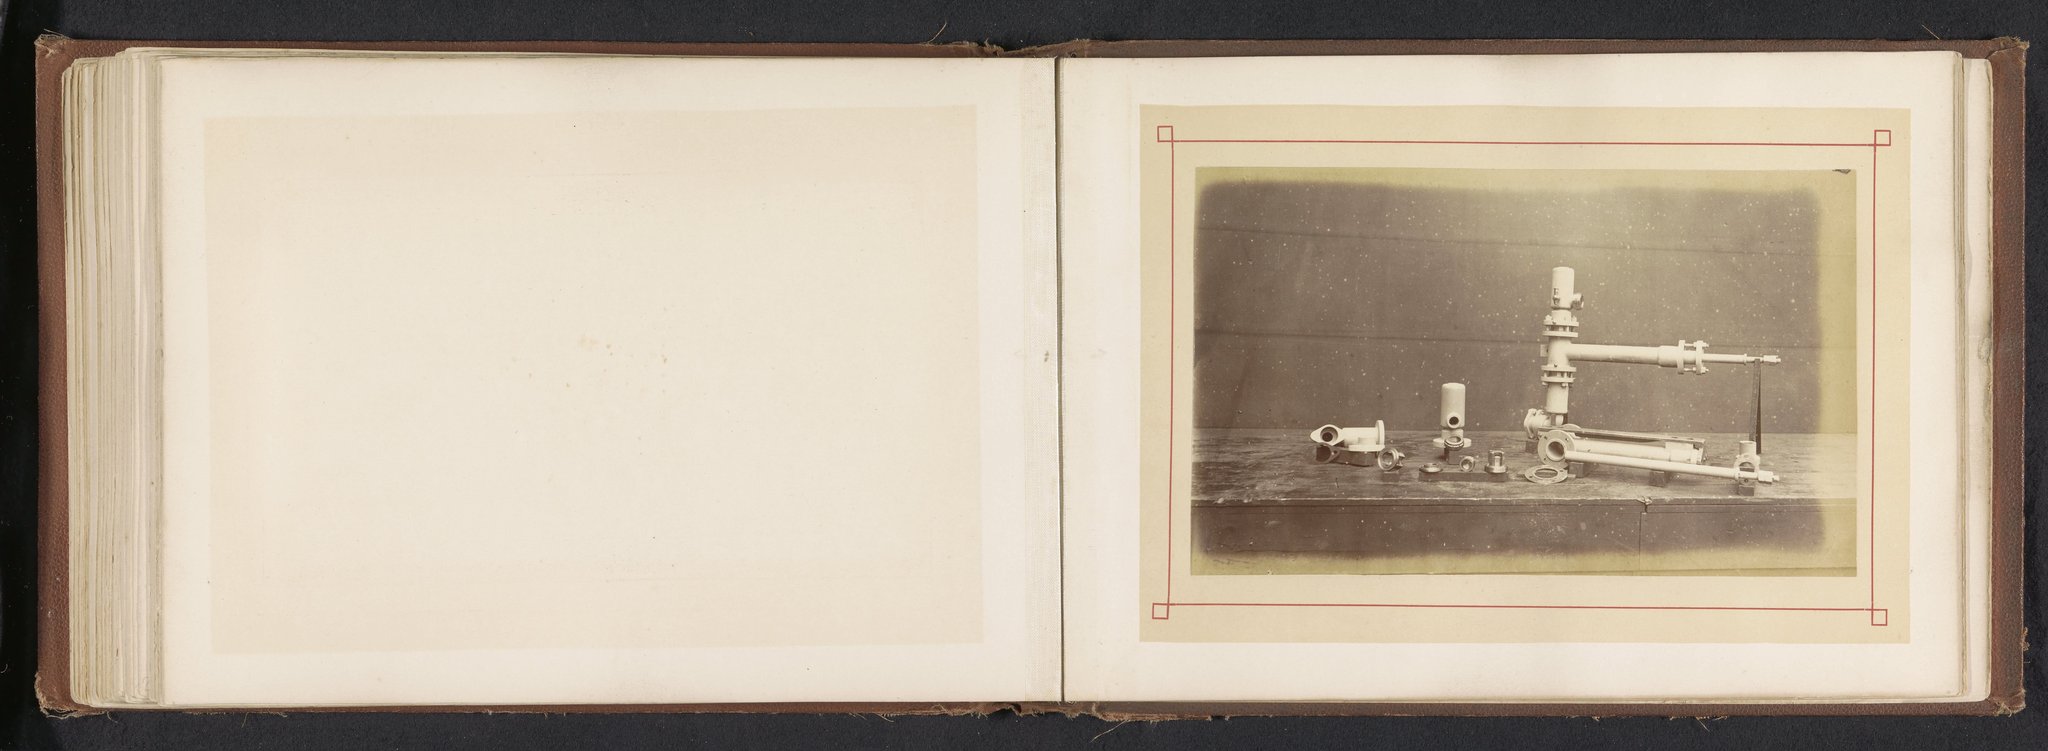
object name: photograph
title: Onderdelen van een stoomlocomotief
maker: george gardner rockwood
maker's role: fotograaf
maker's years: 1832-1911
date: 1861-1871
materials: photographic support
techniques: albumen print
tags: steam locomotive